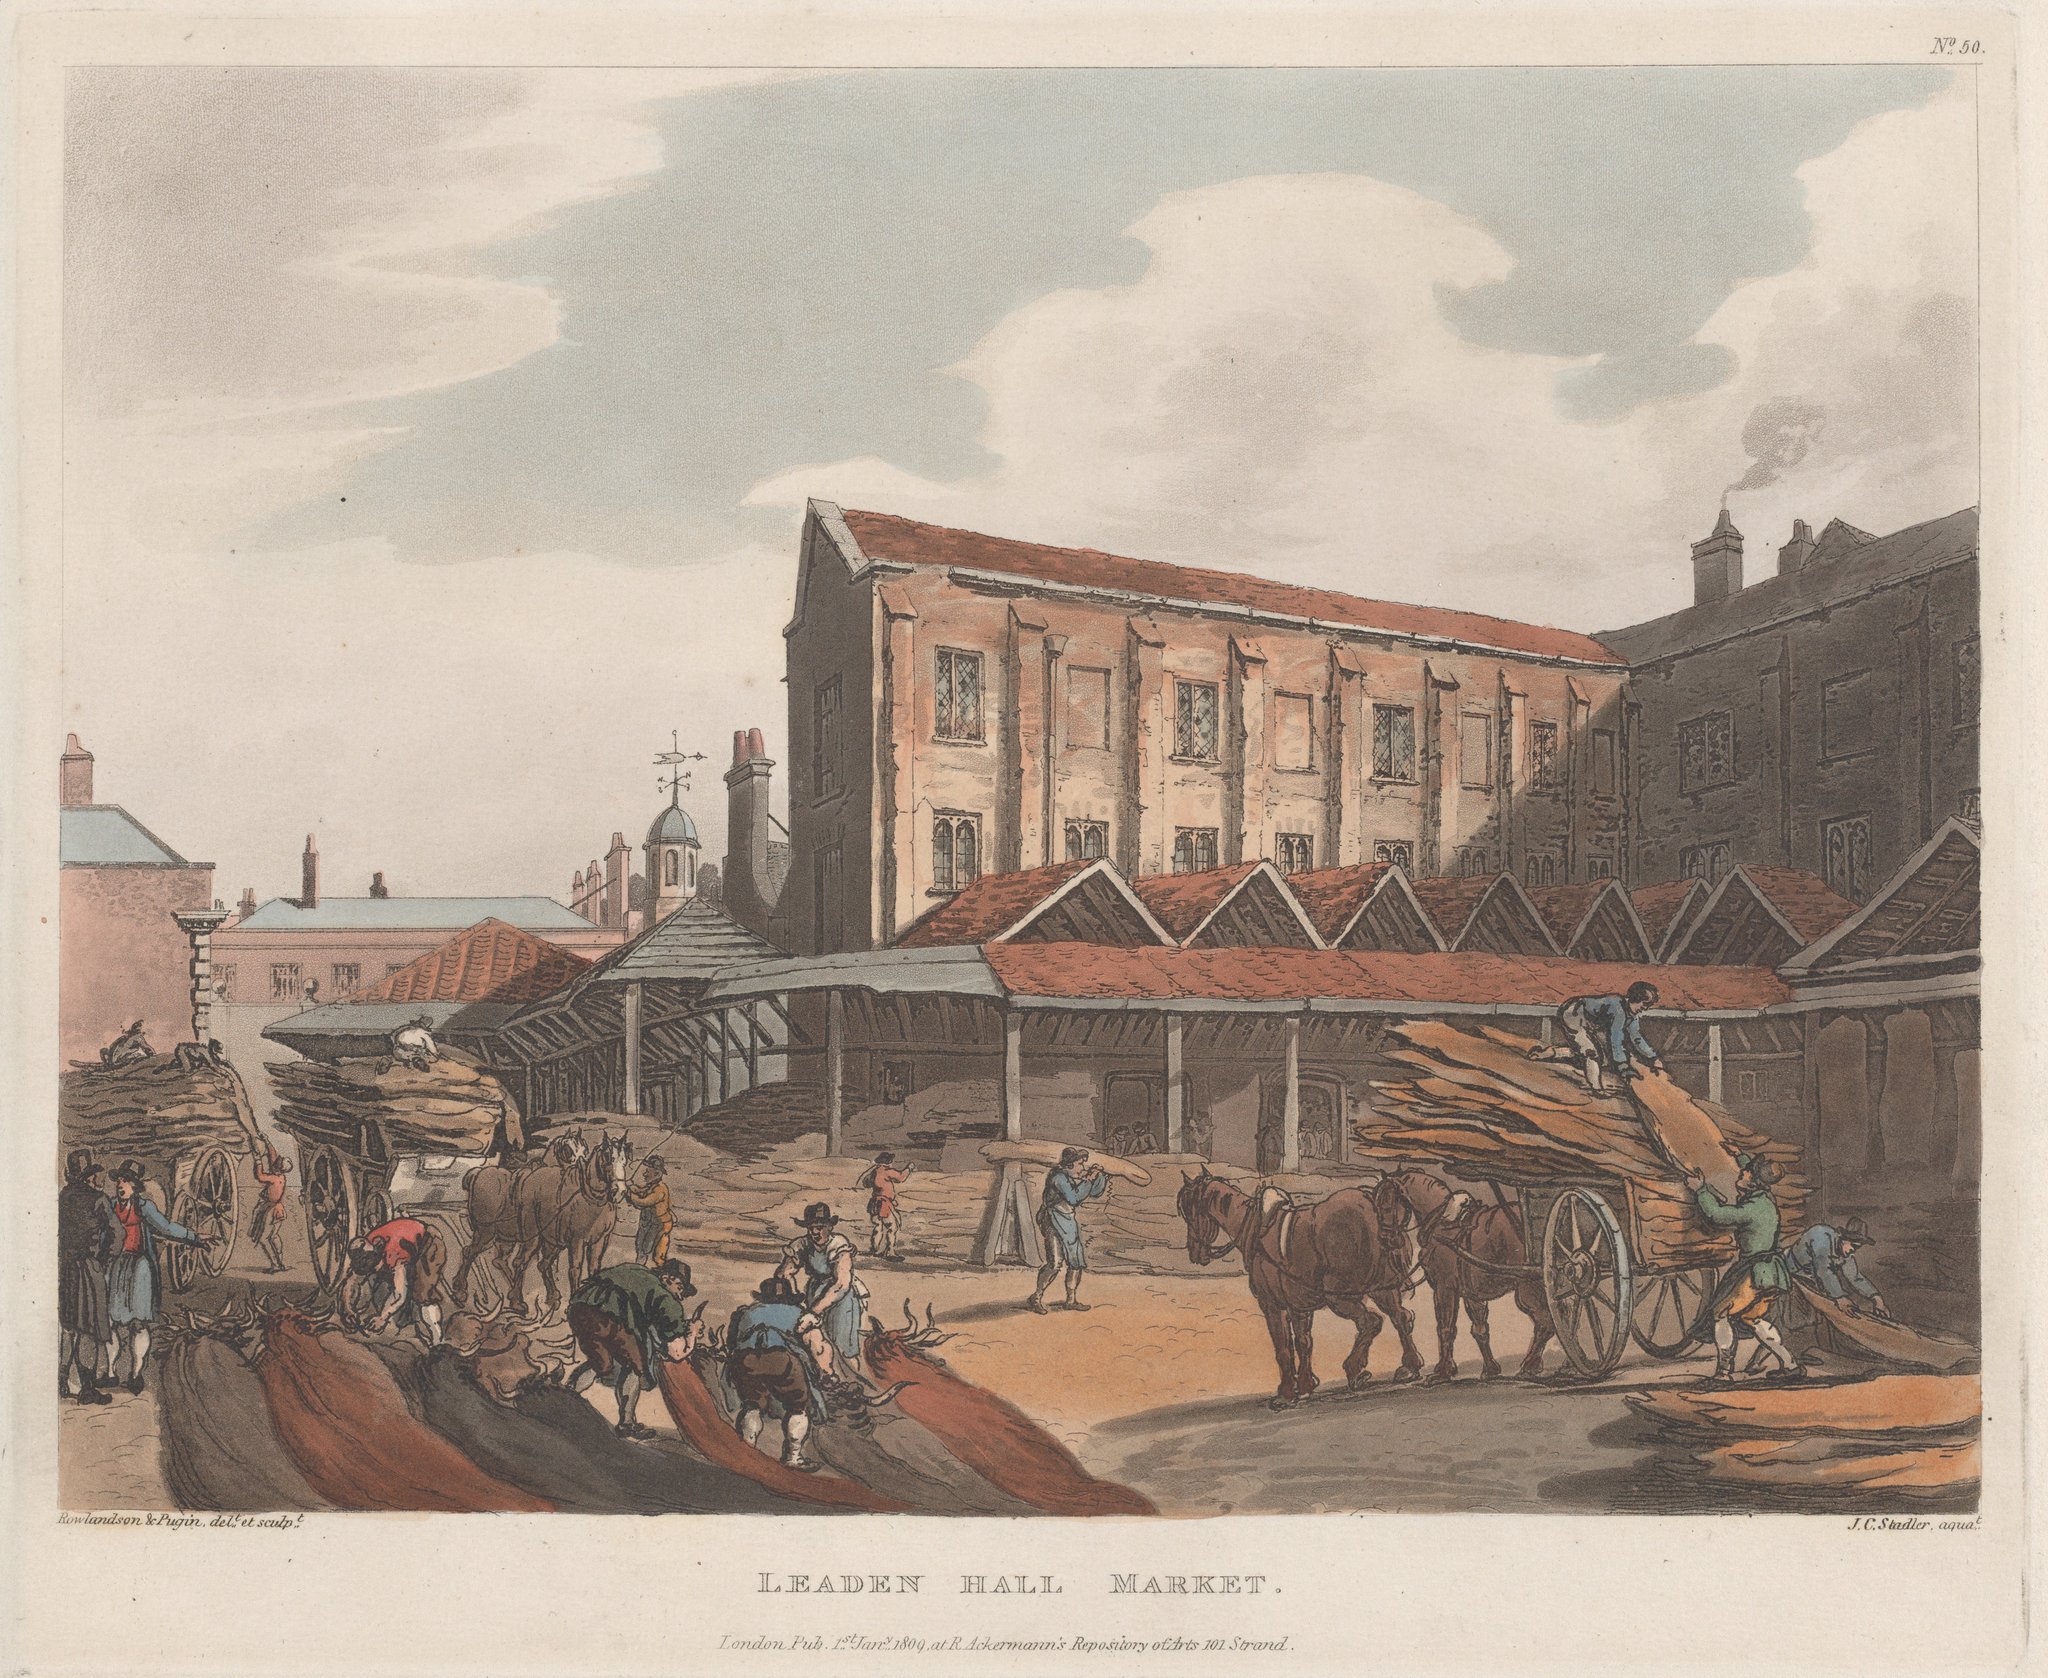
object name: print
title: Leaden Hall Market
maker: thomas rowlandson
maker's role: artist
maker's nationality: british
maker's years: 1757-1827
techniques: aquatint, etching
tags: cities,markets,london